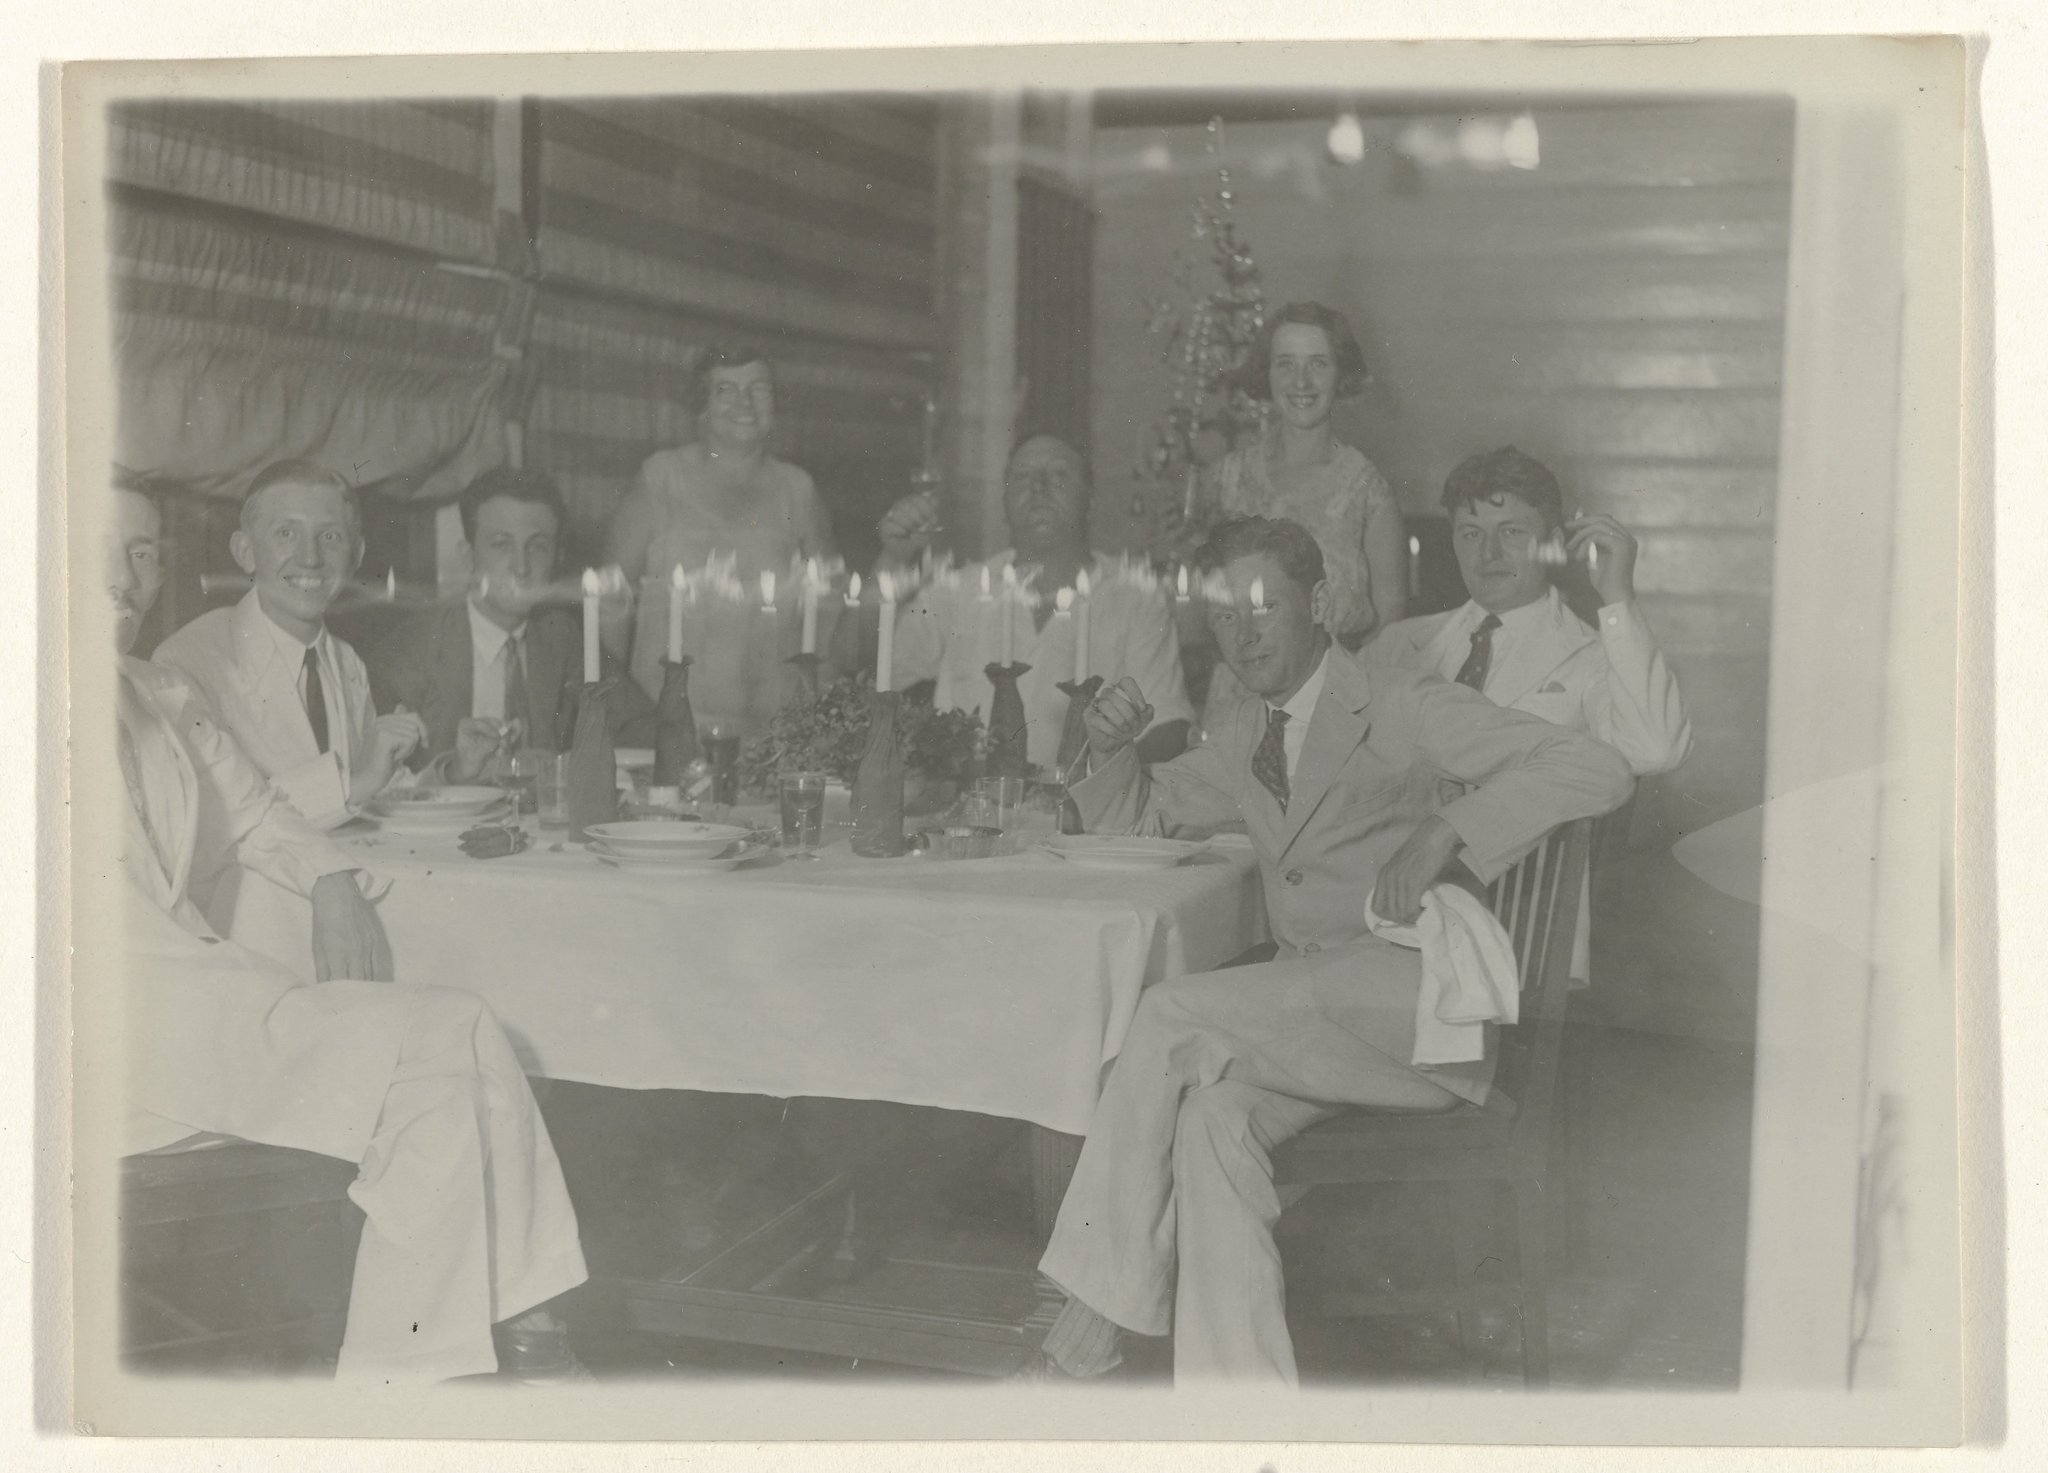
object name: photograph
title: Kerstfeest in Moengo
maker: Anonymous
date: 1930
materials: photographic support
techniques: photography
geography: suriname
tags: christmas (non-liturgical celebration)